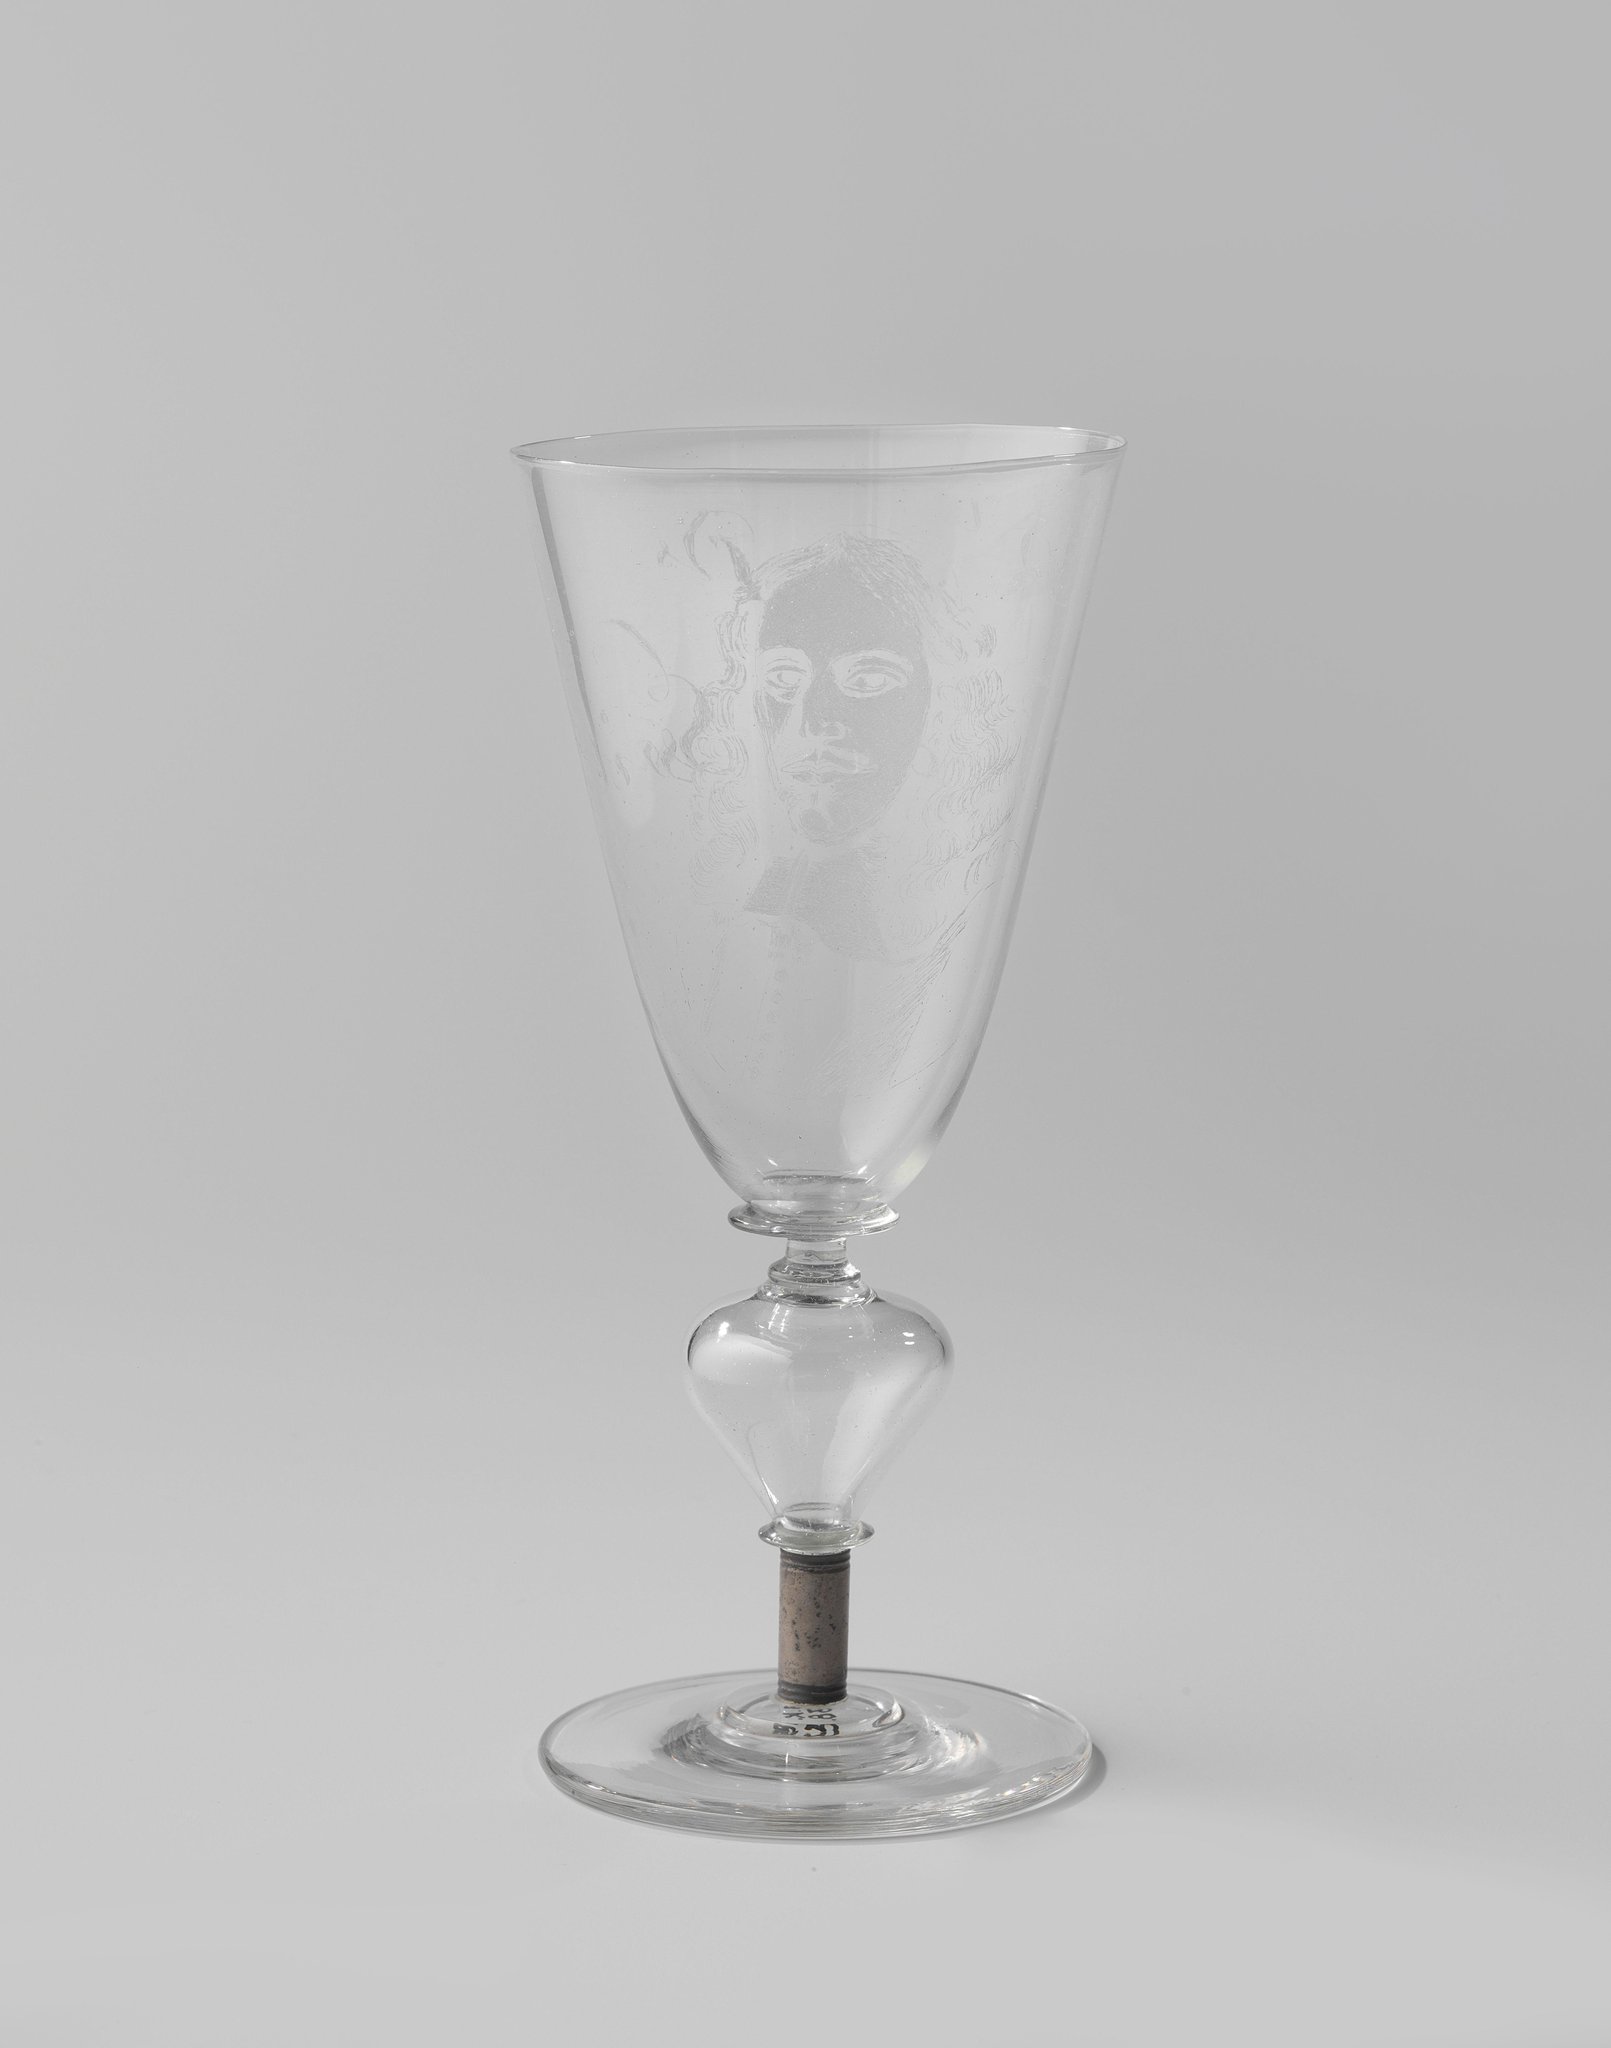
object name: goblet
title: Kelkglas met een portret van Johan de Witt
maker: Anonymous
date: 1650-1700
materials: glass, silver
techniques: diamond point engraving, façon de venise, glassblowing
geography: low countries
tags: the hague, politician, johan de witt, netherlands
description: Platte nieuwe voet met omgeslagen rand. Balustervormige stam met een verbindingsstuk van zilver en twee schijven. Conische, aan de onderzijde afgeronde kelk waarop gegraveerd is een portret van Johan de Wit. Op de keerzijde het opschrift Rt.Ps J de Wit. Raadpensionaris.